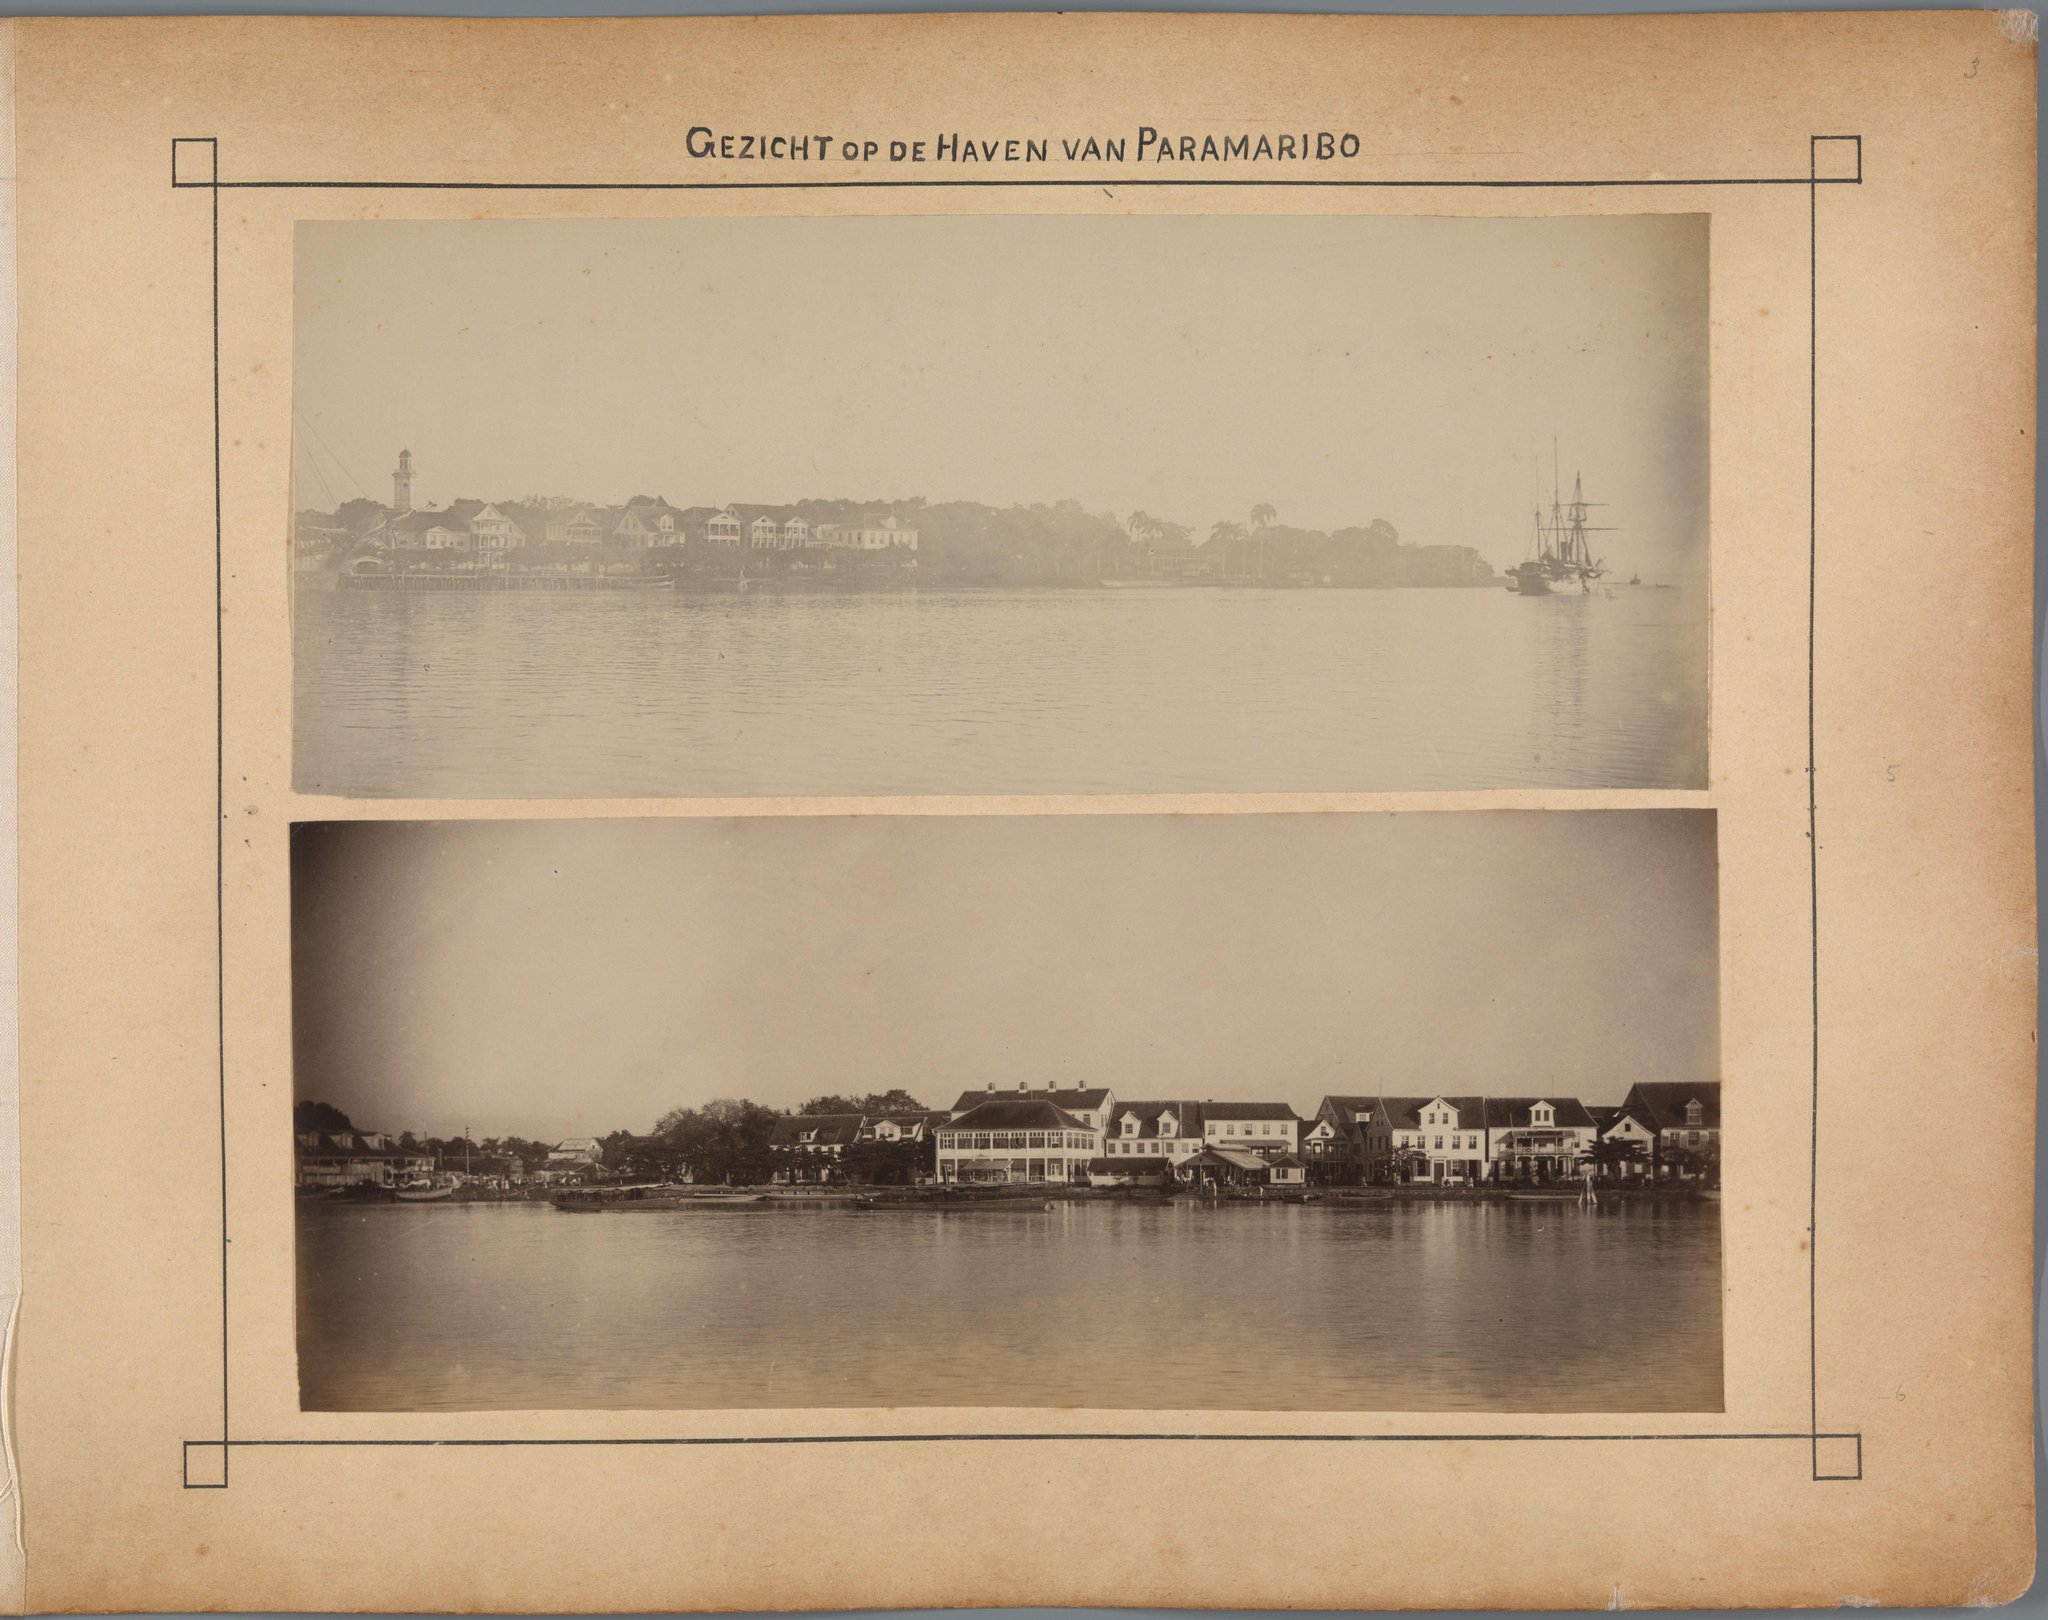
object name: photograph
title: Gezicht op haven van Paramaribo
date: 1898-1902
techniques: albumen print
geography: suriname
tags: suriname